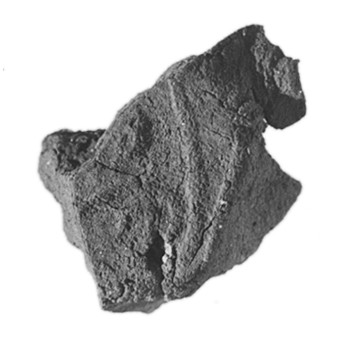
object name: sealing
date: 2030-1640 BCE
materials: clay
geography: egypt